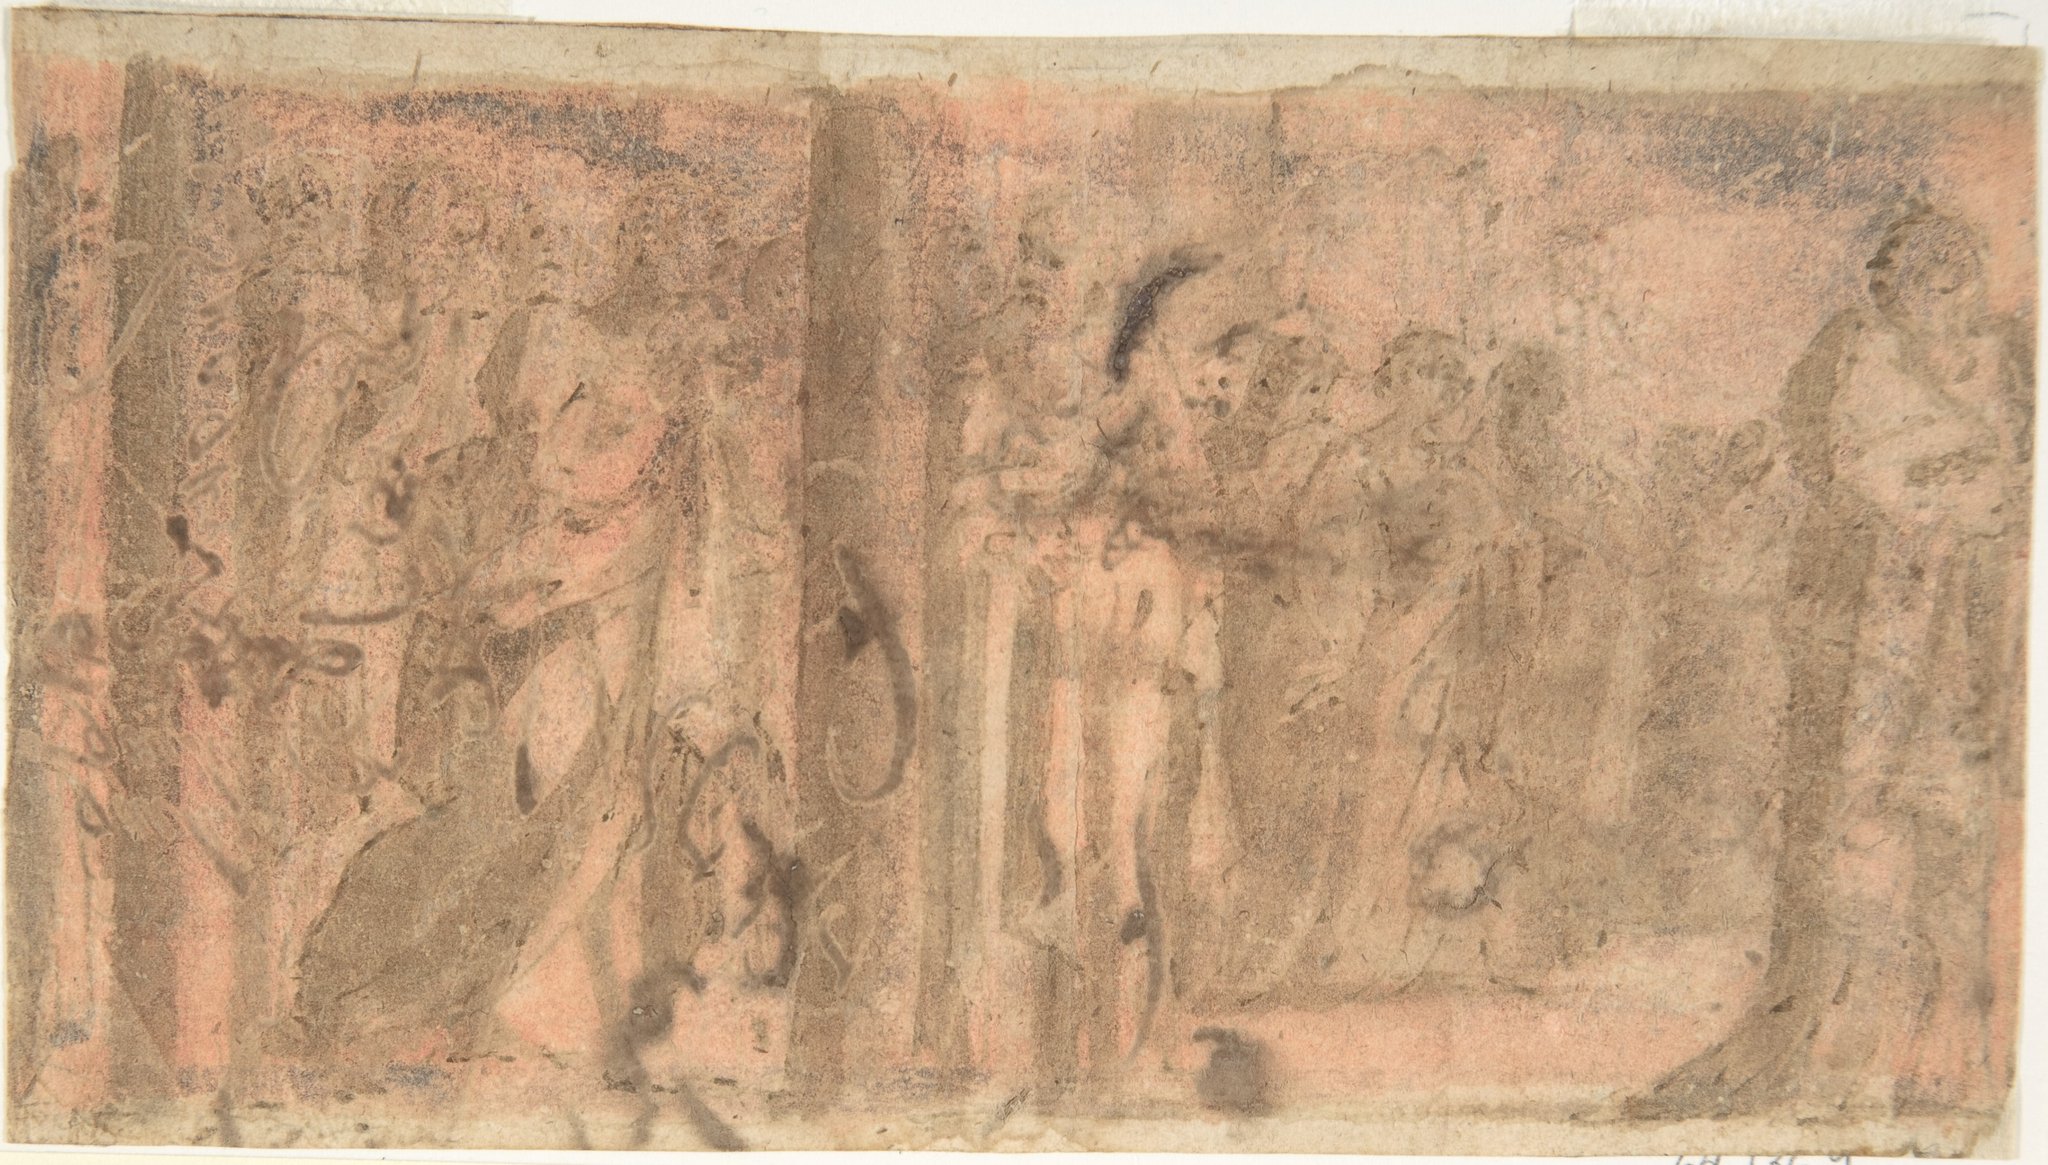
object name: drawing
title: Study of a Scene of Martyrdom (recto); Study of Three Figures (verso)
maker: anonymous, italian, 16th century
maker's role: artist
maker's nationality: italian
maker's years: 1550-1600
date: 1501-1600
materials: ink, paper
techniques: brush, pen, wash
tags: human figures